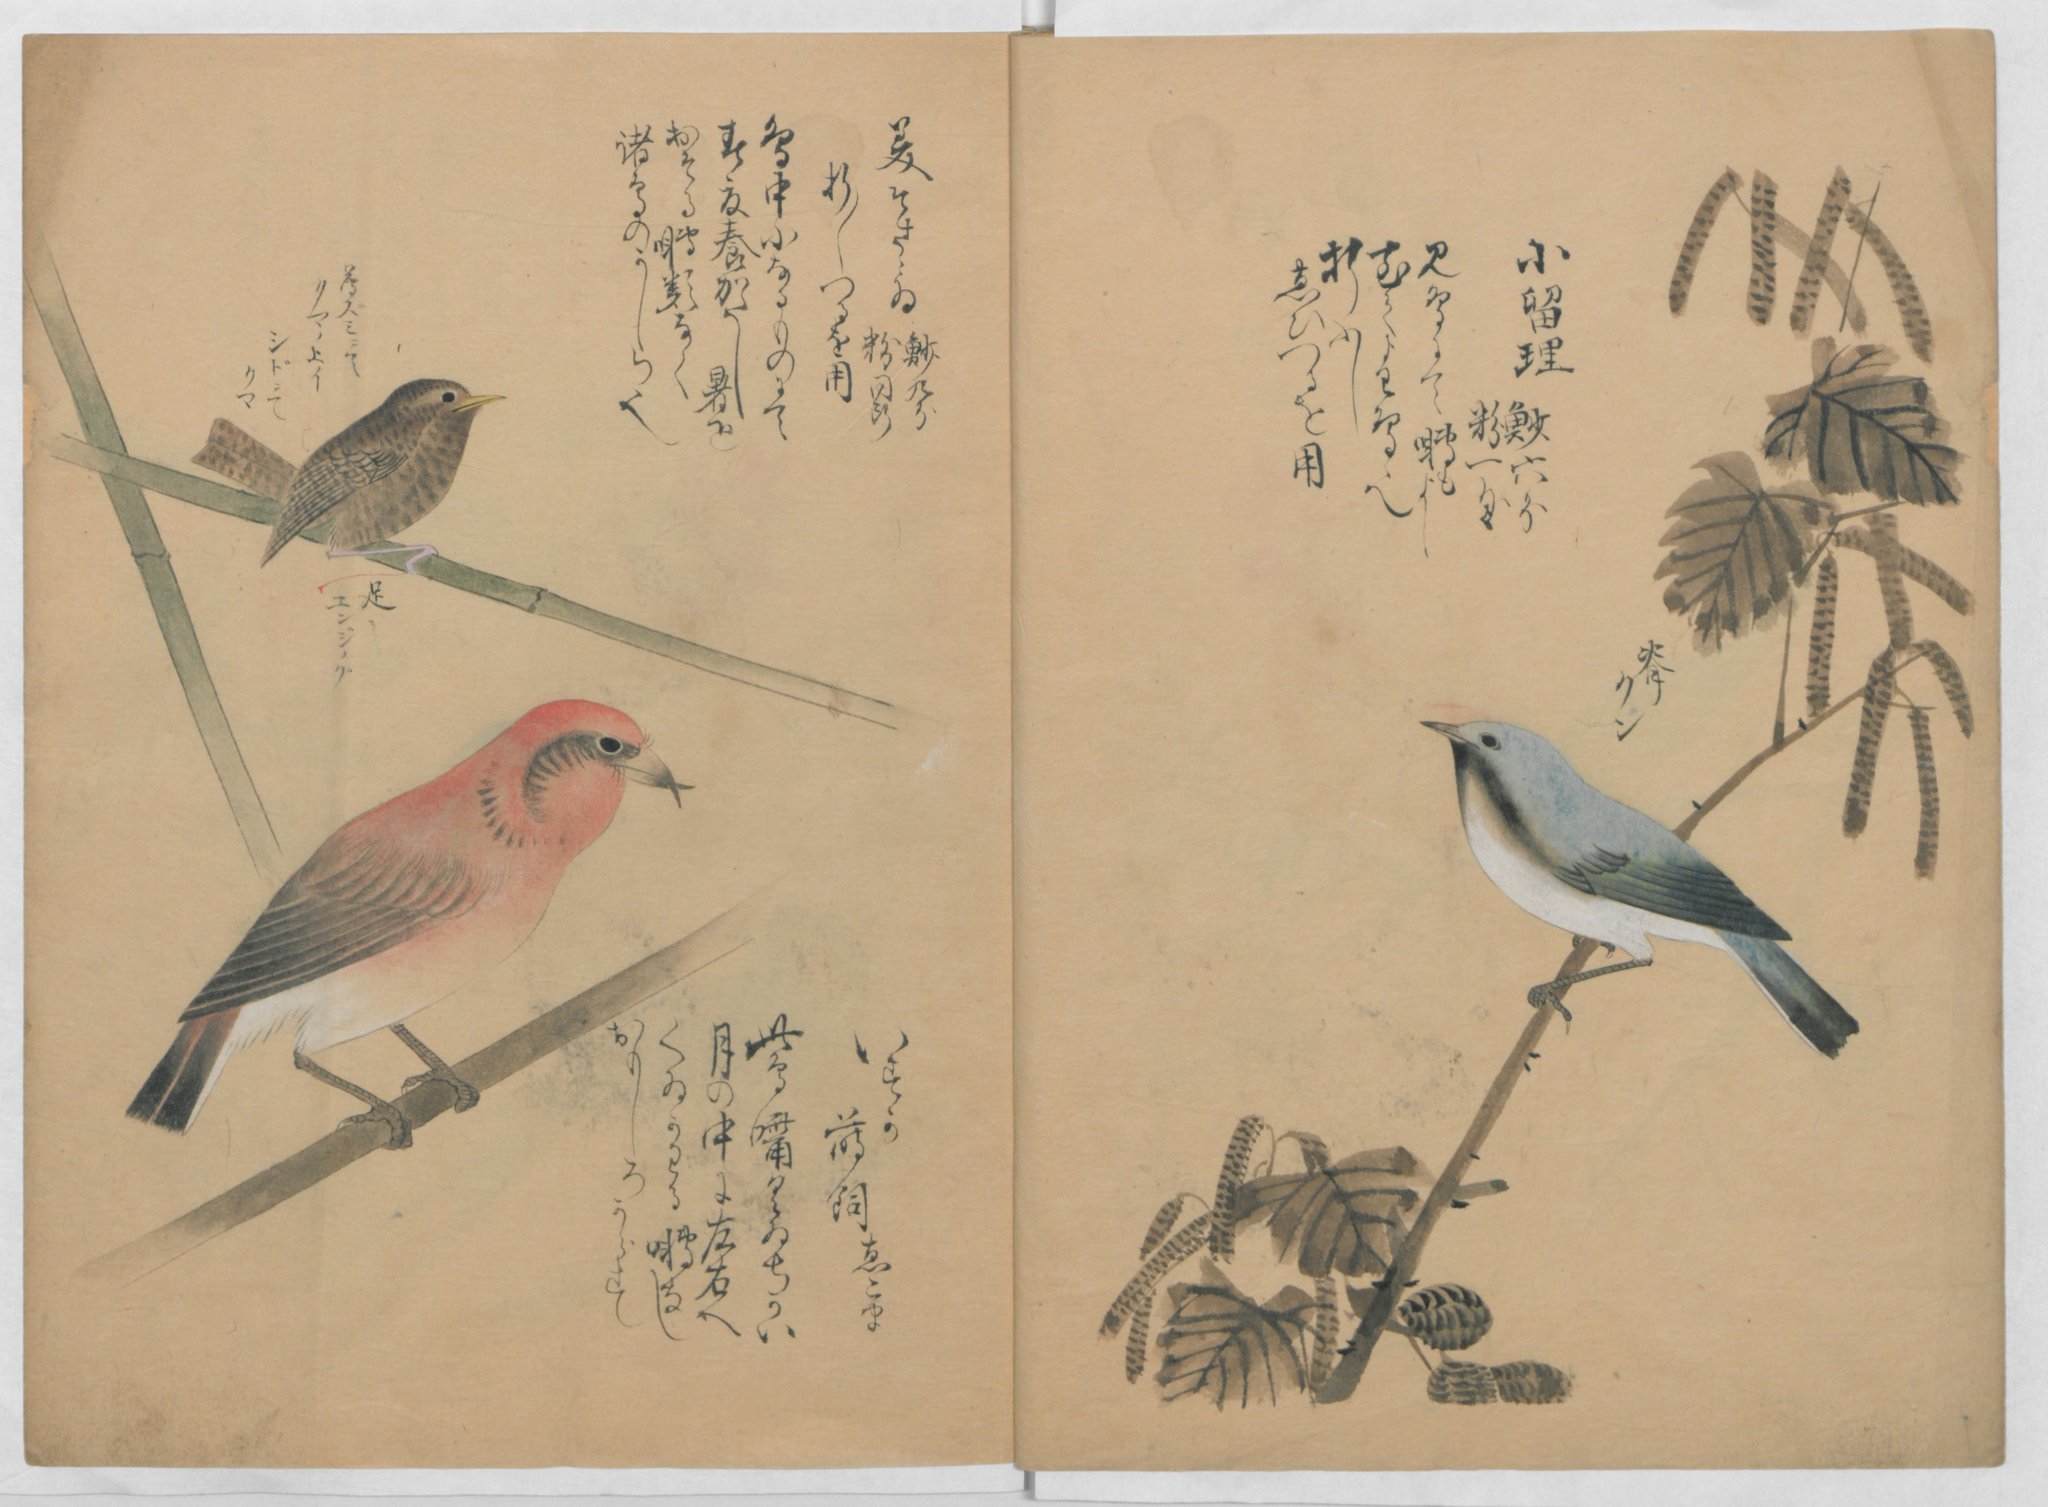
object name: illustrated book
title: A Compendium of Small Birds (Kotori rui shū) 小鳥類集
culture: japanese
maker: nantō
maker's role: artist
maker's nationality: japanese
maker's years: 1800-1835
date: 1836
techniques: polychrome, woodblock print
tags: birds